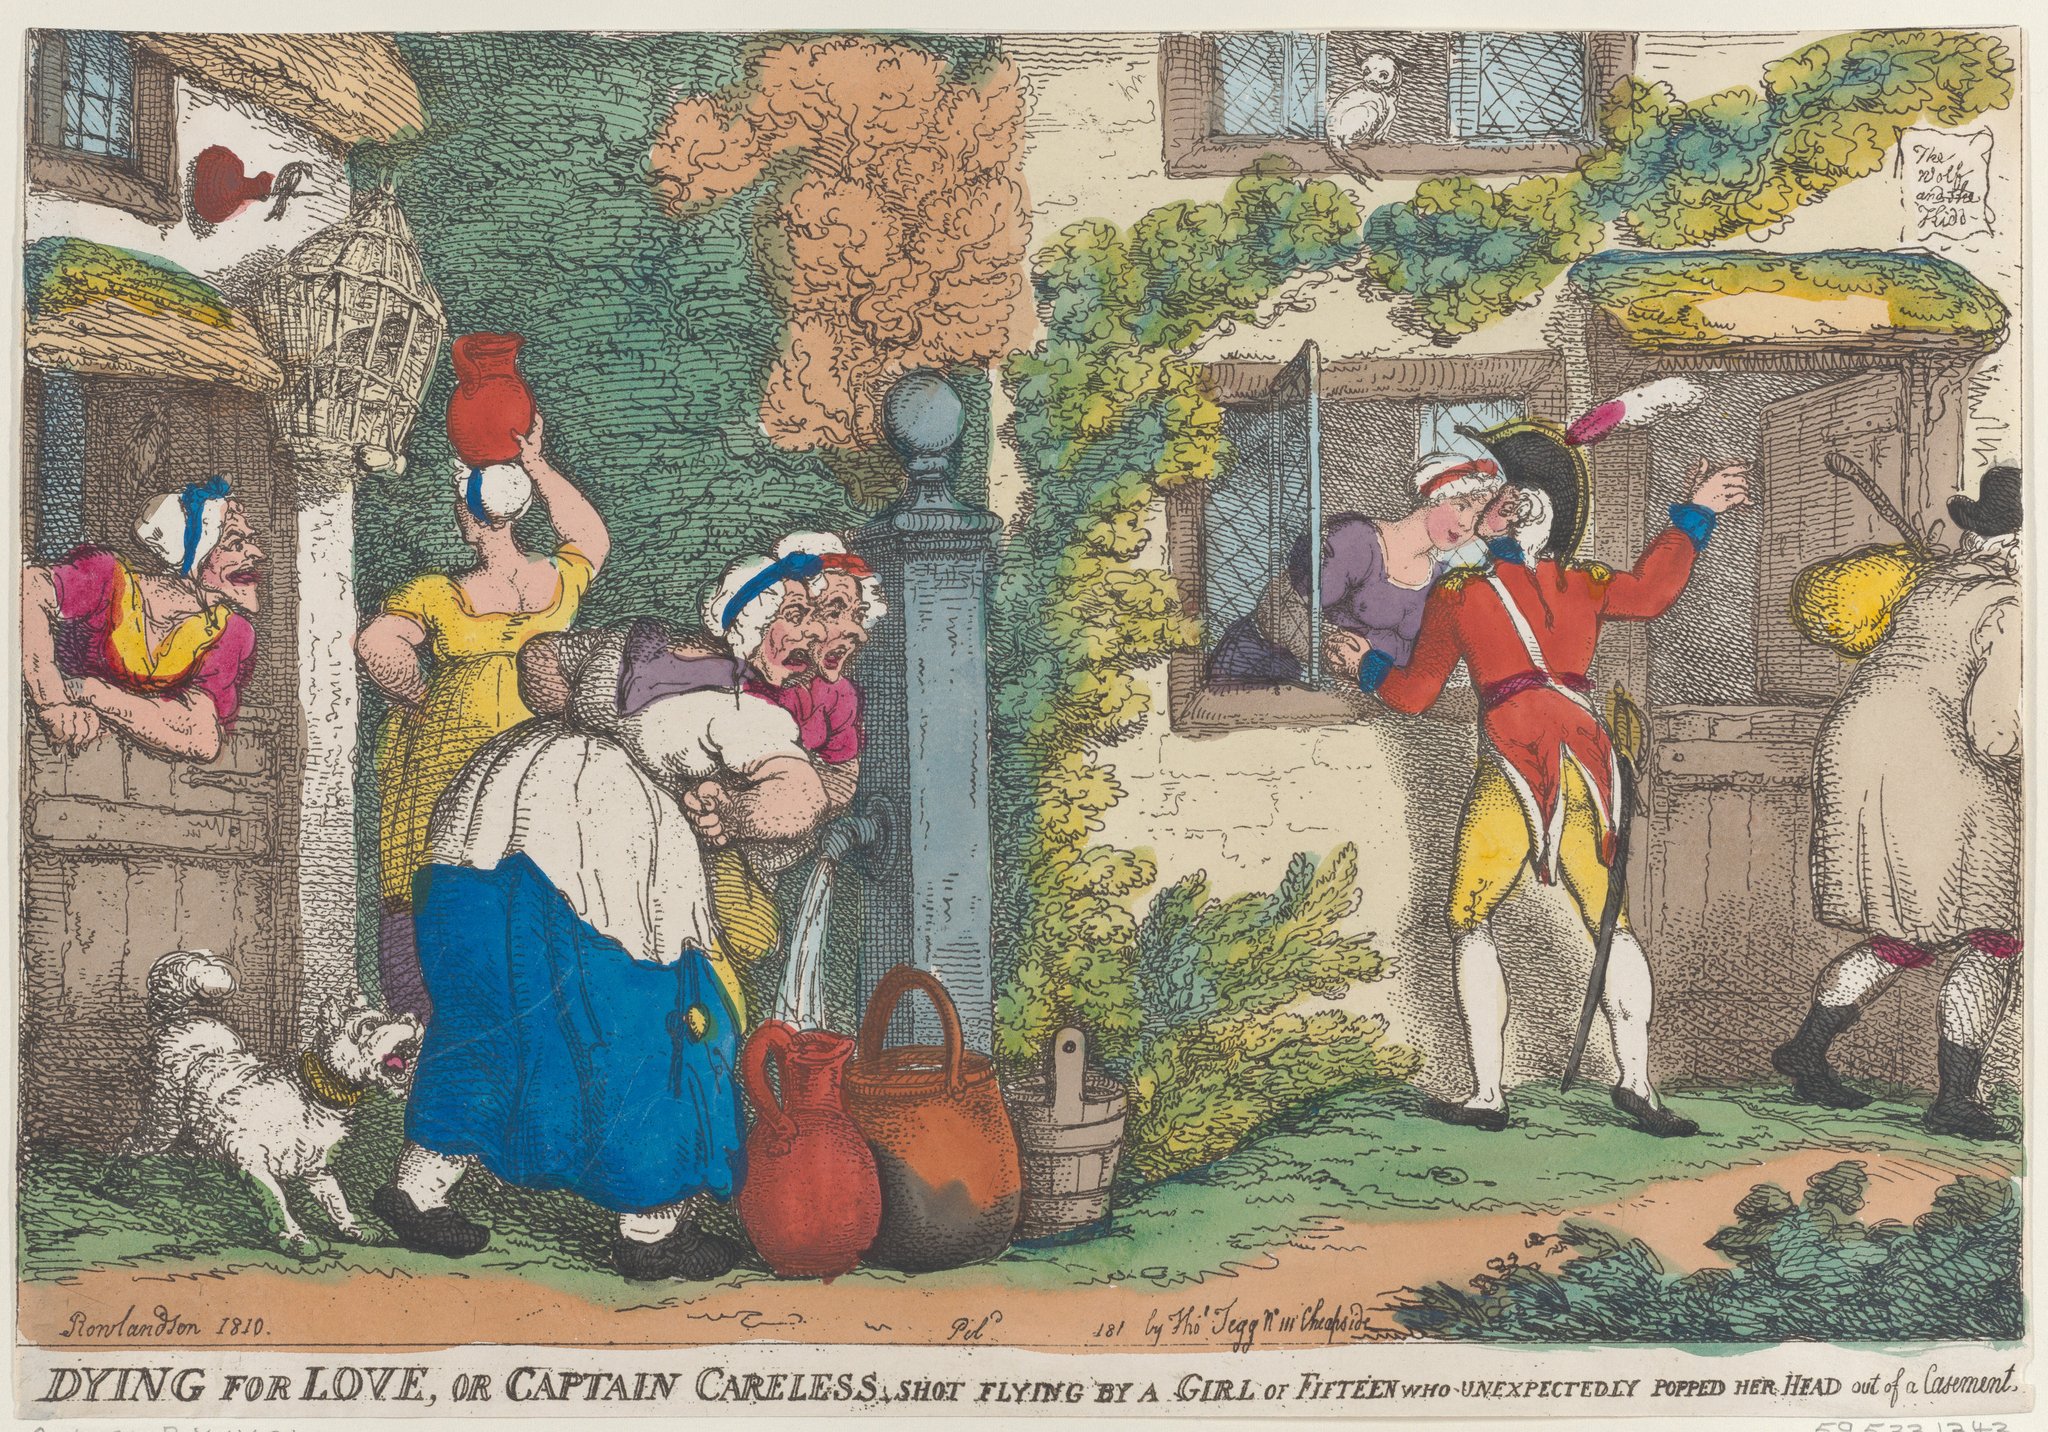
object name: print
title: Dying for Love, or Captain Careless, Shot Flying by a Girl of Fifteen who Unexpectedly Popped Her Head out of a Casement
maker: thomas rowlandson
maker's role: artist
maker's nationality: british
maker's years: 1757-1827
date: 1810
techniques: etching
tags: satire,men,women,dogs